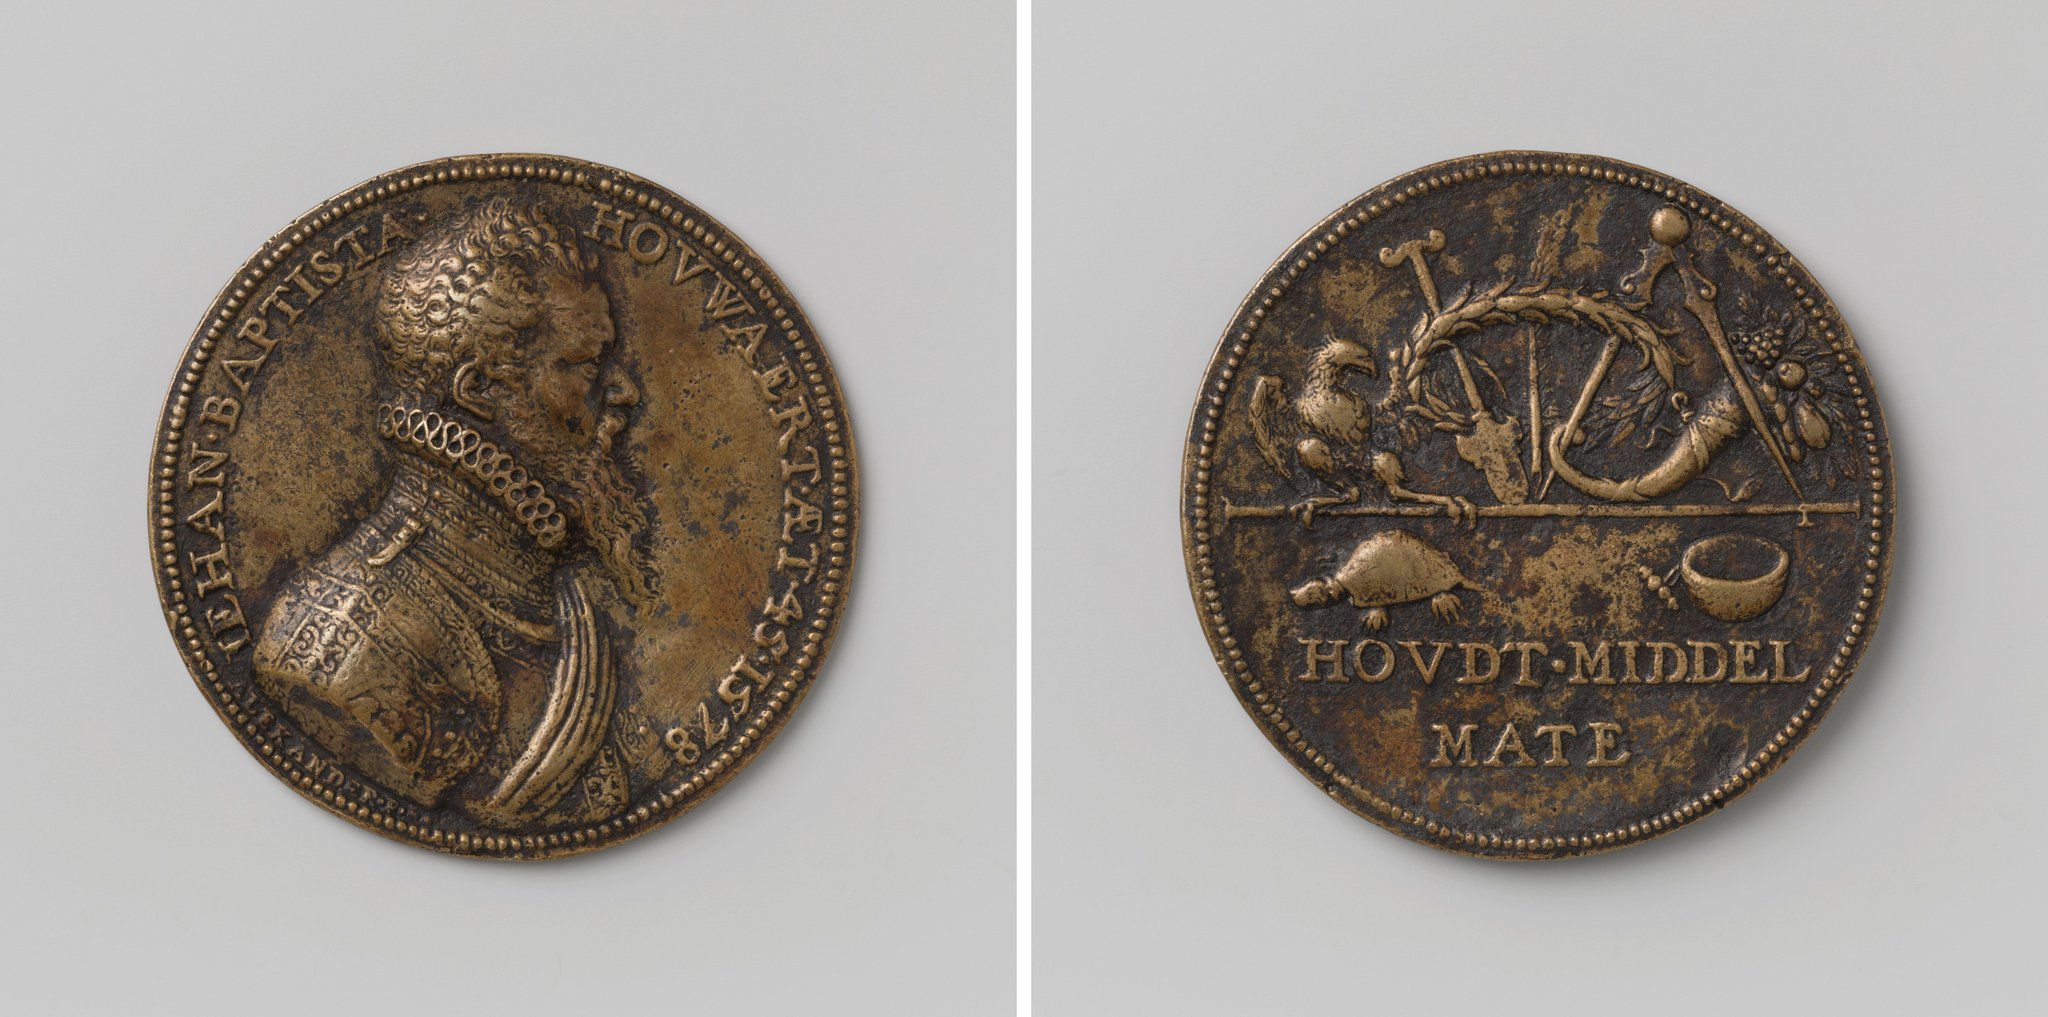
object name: medal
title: Portret van Johan Baptista Houwaert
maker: alexander p. bruxellensis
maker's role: jeweler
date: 1578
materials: bronze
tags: historical persons, brussels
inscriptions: : ‘HOUDT.MIDDEL MATE’